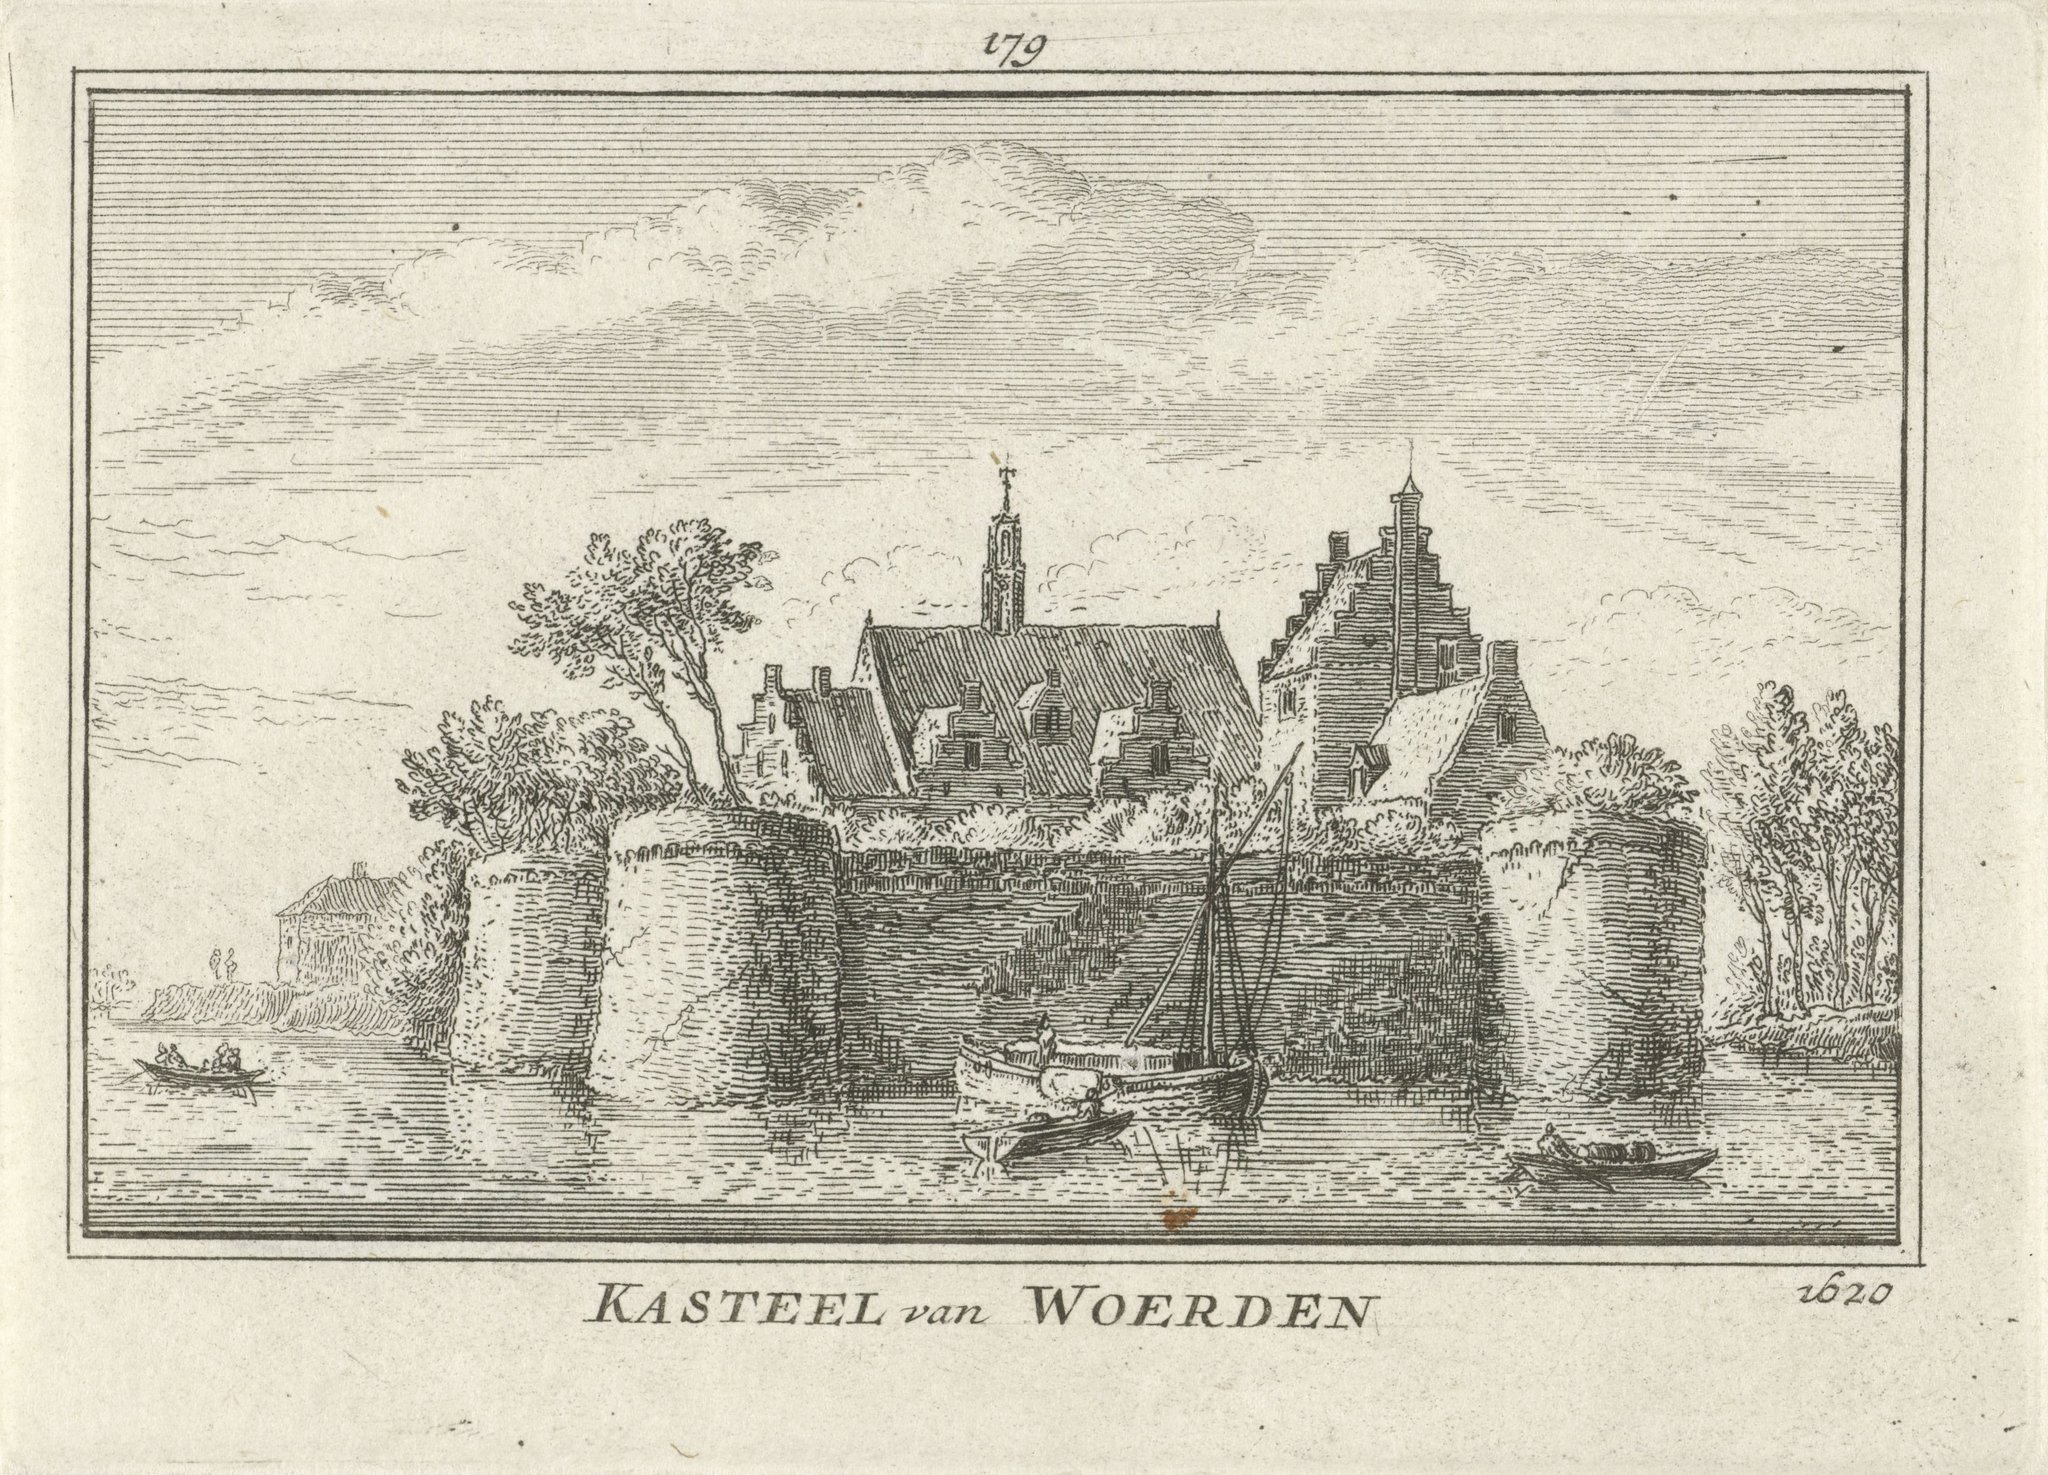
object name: print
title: Gezicht op Slot Woerden, 1620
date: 1727-1733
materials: paper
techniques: etching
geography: amsterdam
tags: sailing-ship, sailing-boat, castle, rowing-boat, canoe, etc.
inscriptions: collector's mark: Lugt 2228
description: Illustratie uit: Abraham Rademaker, Matthaeus Brouërius van Niedek, Isaac Le Long, Kabinet van Nederlandsche en Kleefsche outheden en (...) voorname stads- en landgebouwen, Willem Barents en Antoni Schoonenburg: Amsterdam, 1727-1733, ill. nr. 179.